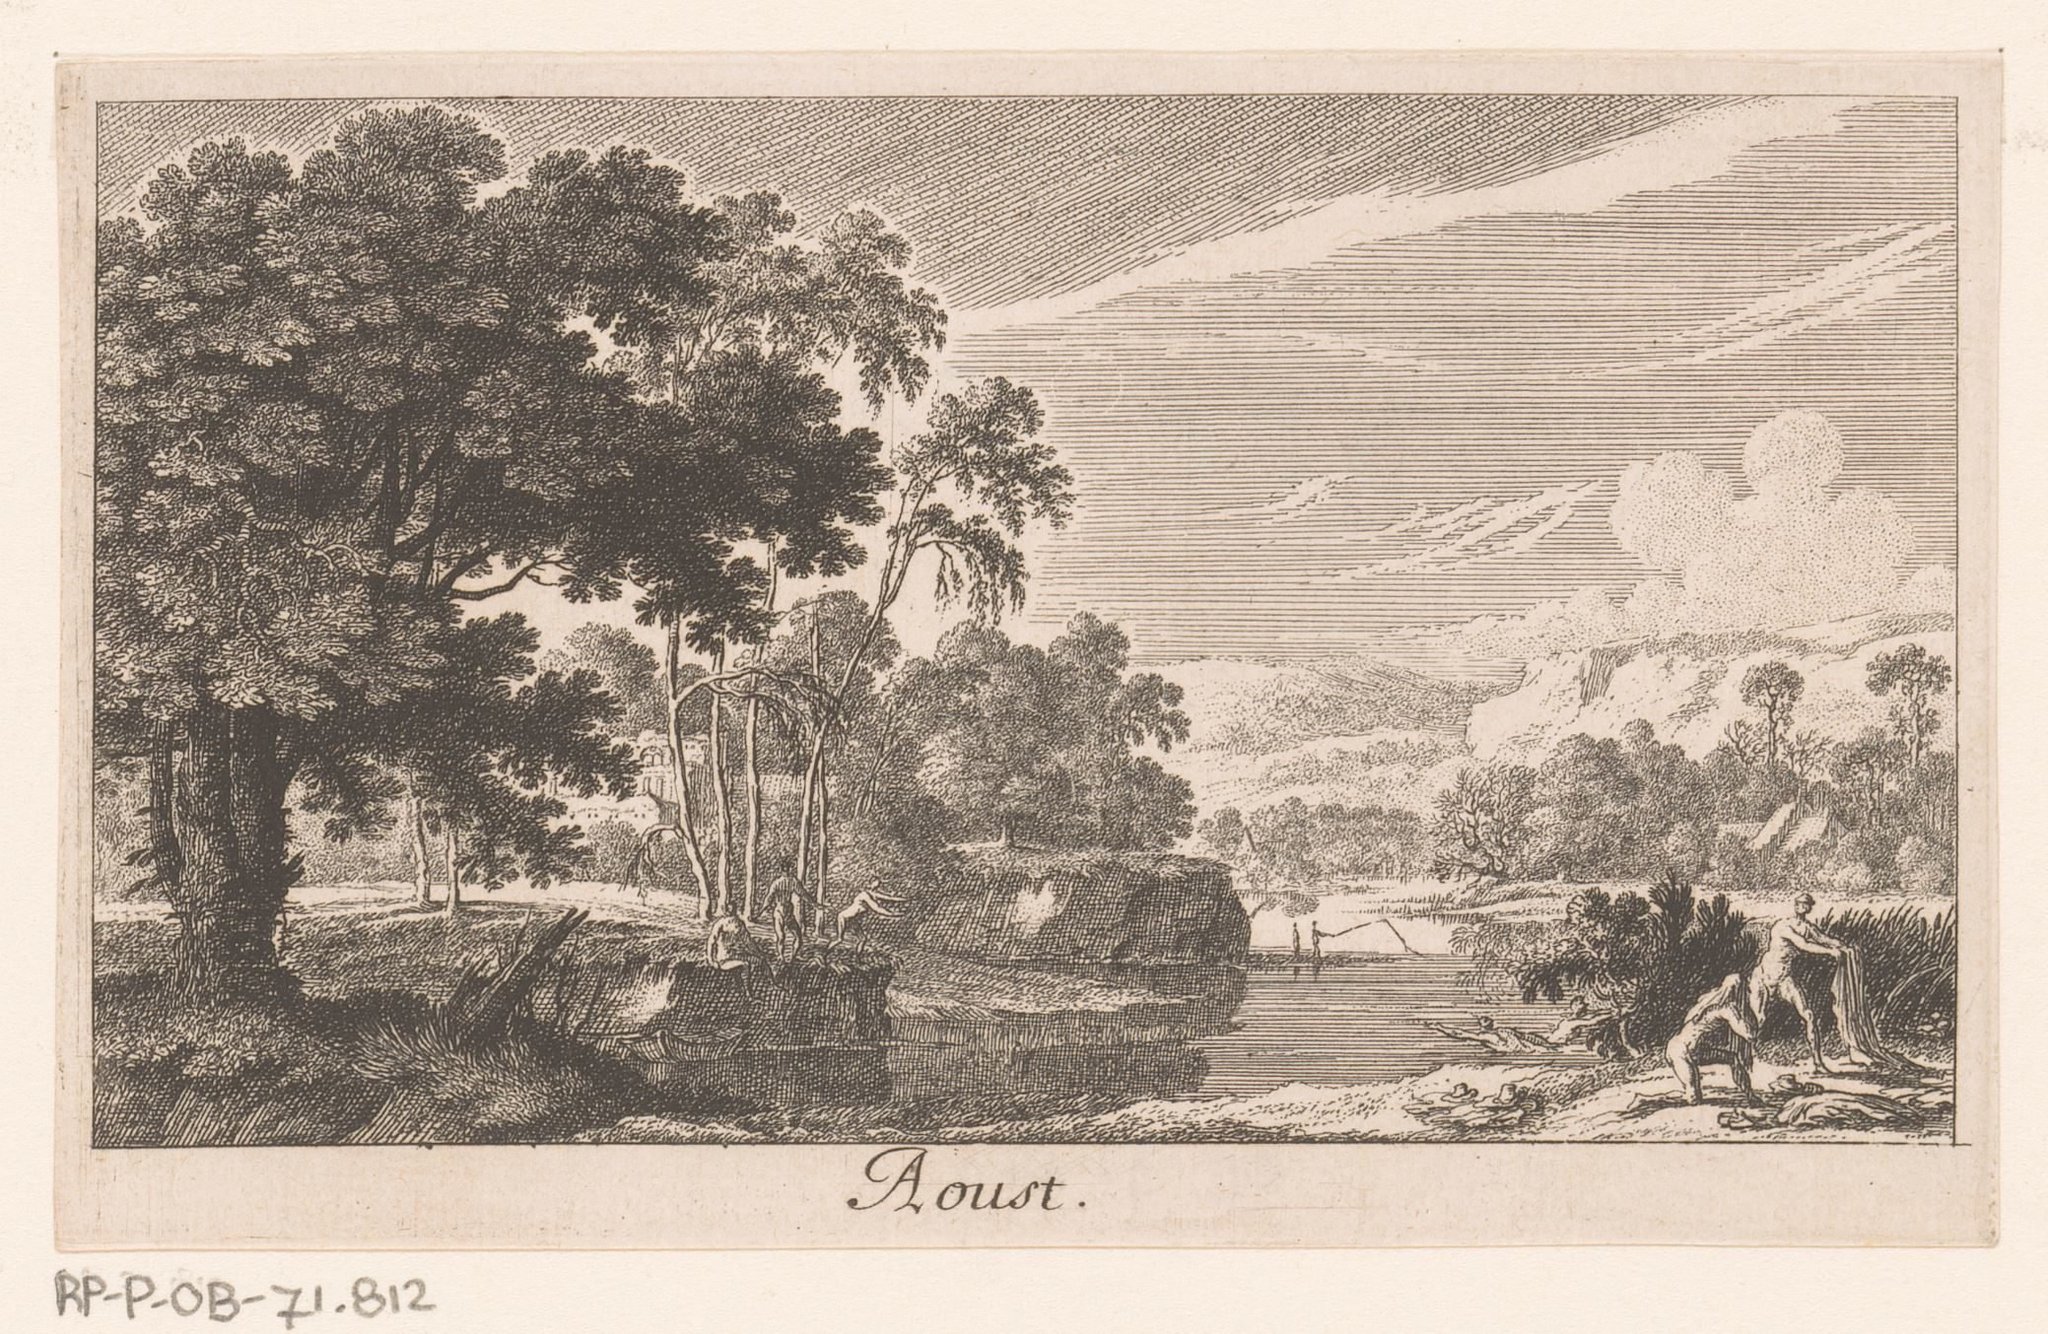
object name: print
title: Twaalf maanden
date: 1613-1655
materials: paper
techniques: engraving, etching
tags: landscape symbolizing august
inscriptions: collector's mark: Lugt 240